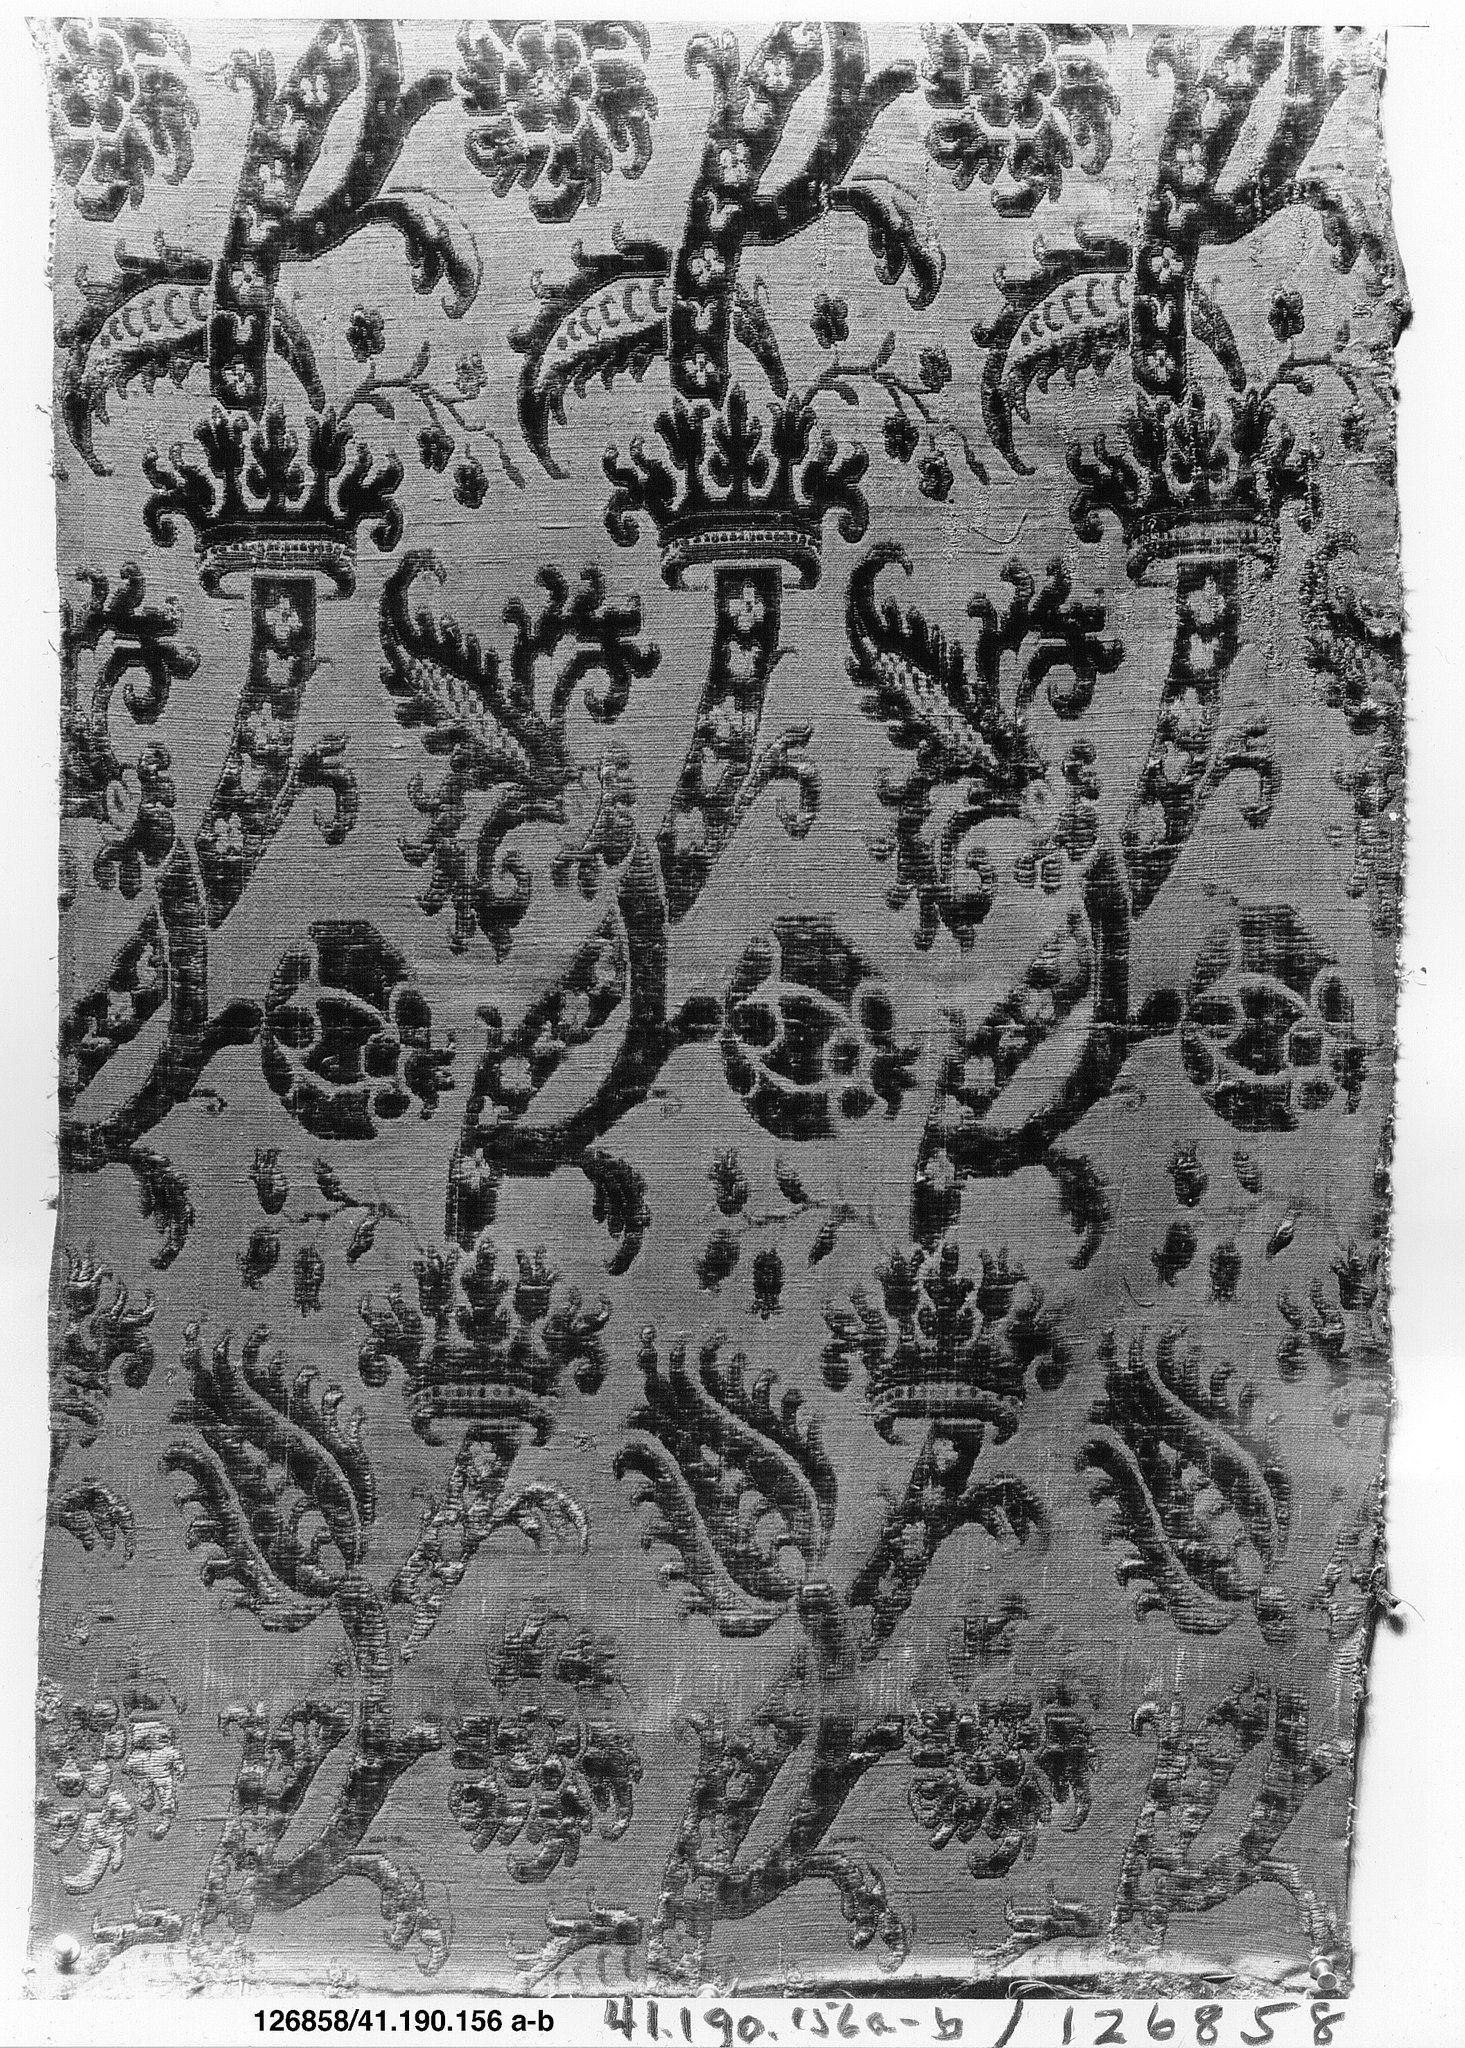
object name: piece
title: Pieces (2)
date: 1601-1700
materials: silk